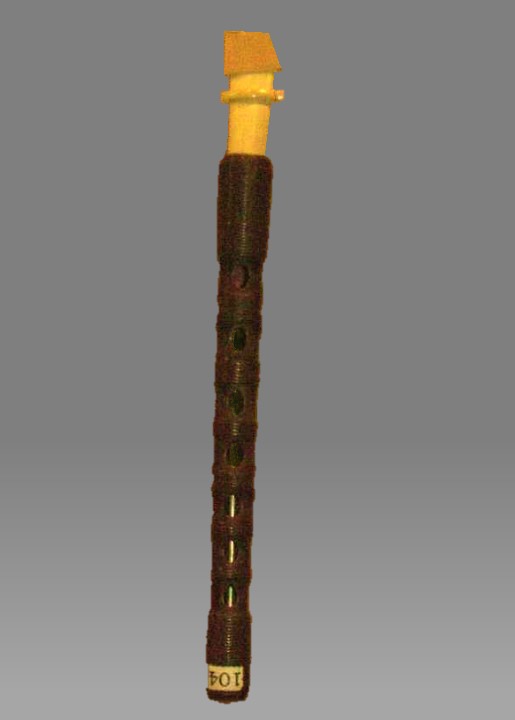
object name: hichiriki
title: Hichiriki (篳篥)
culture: japanese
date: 1801-1900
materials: bamboo, wood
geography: japan